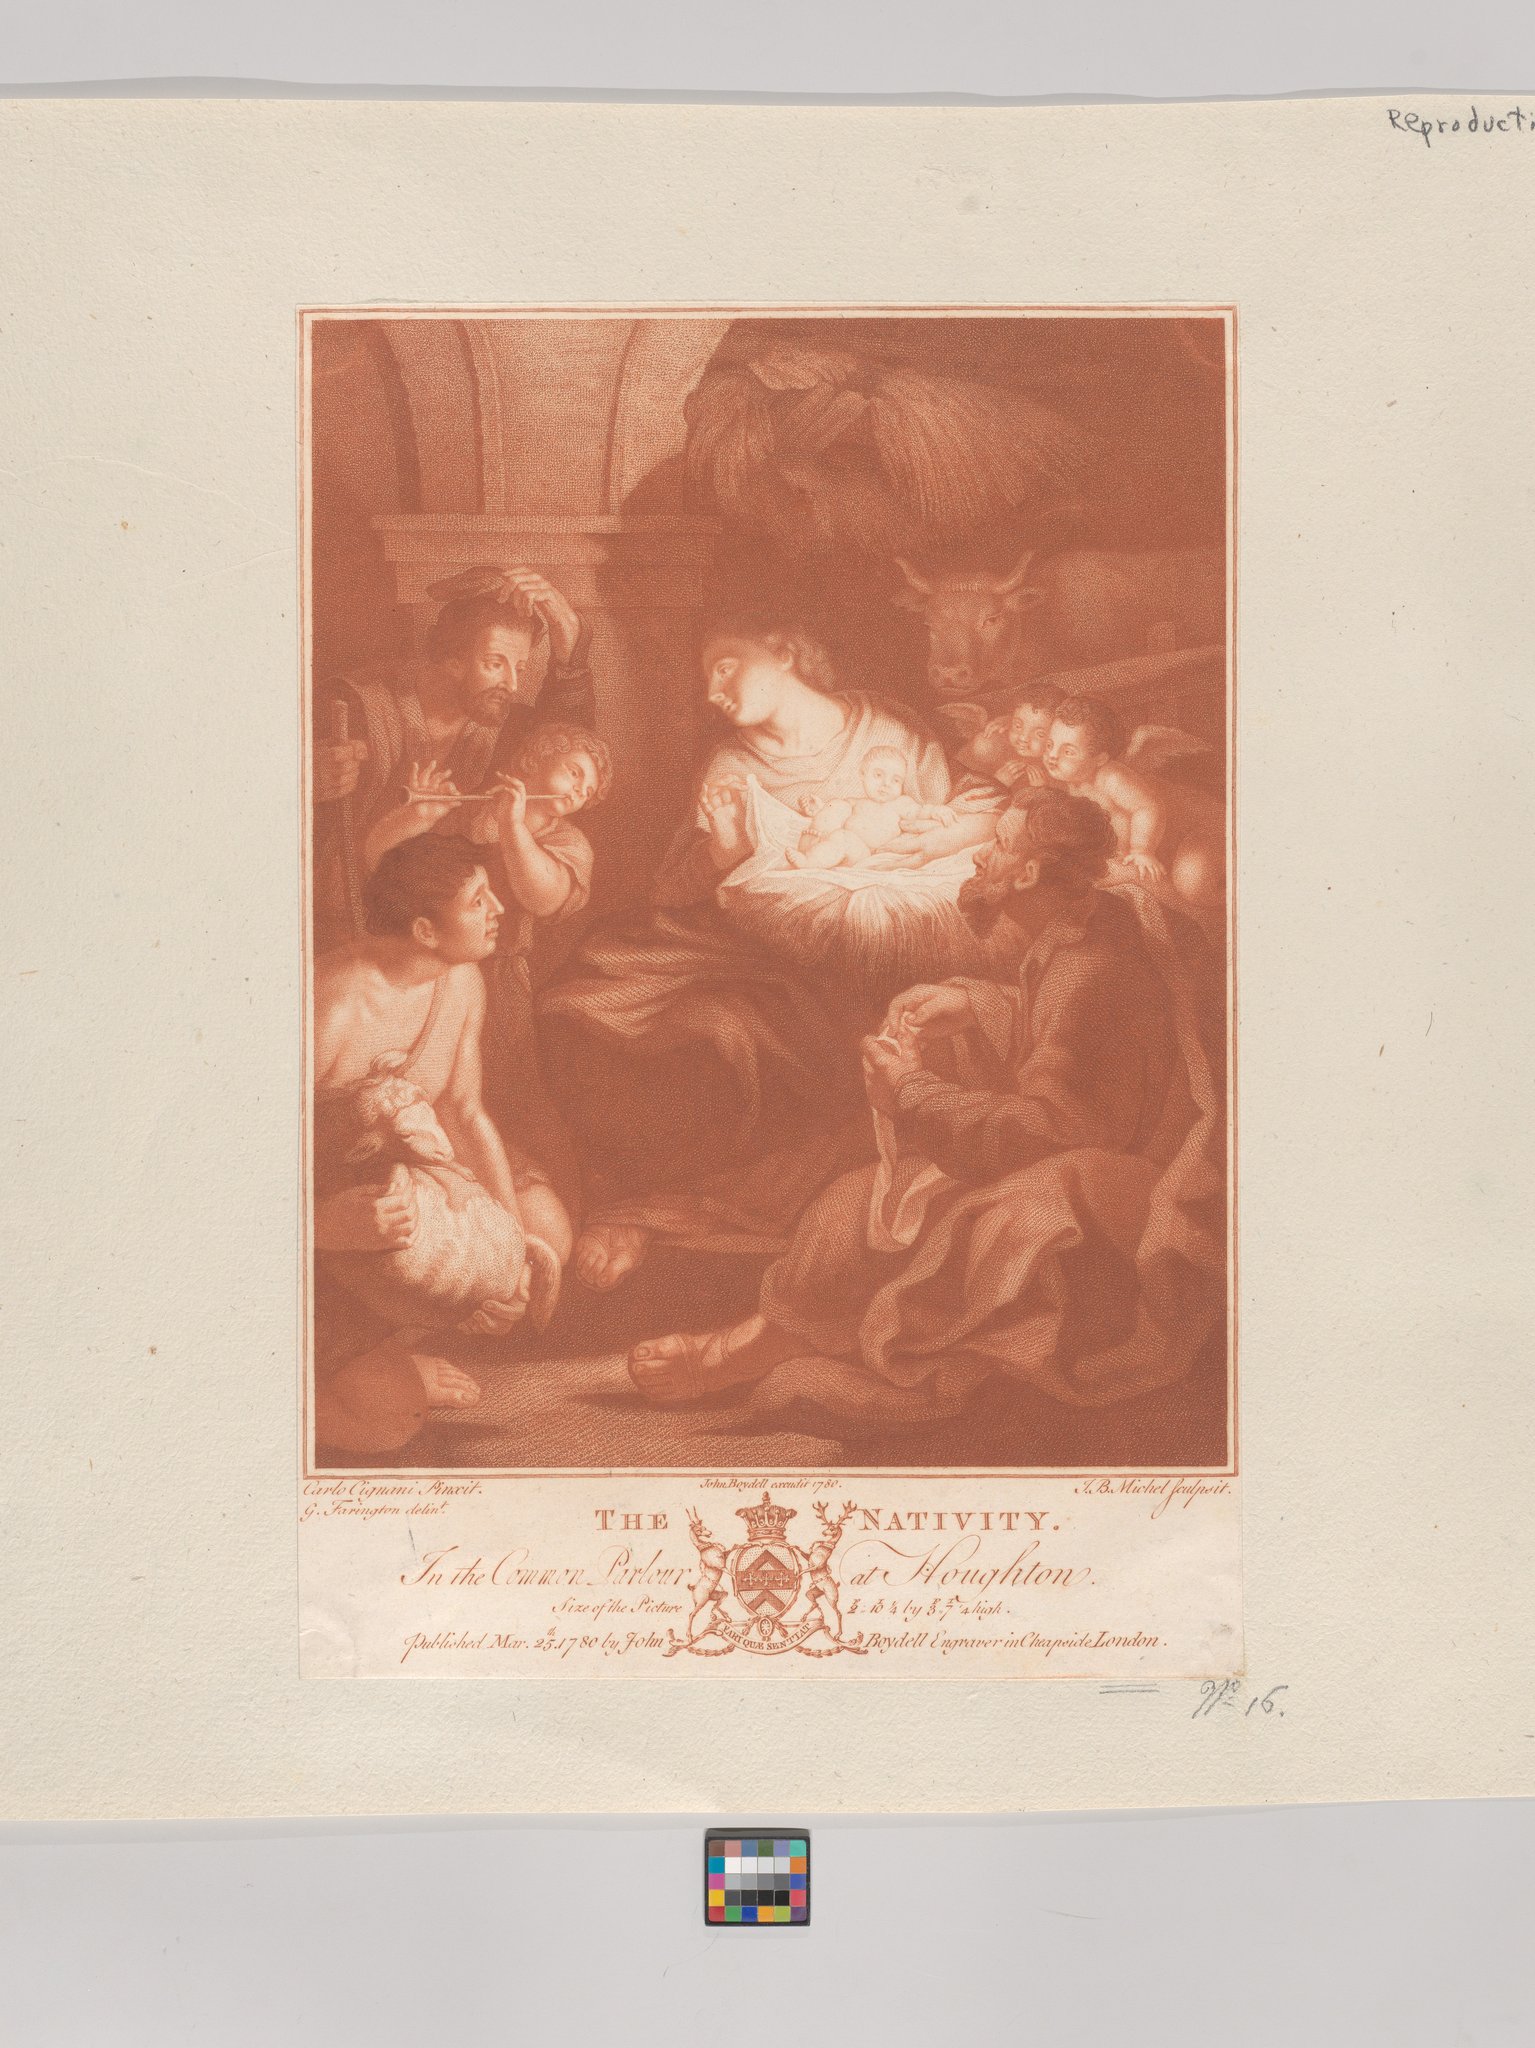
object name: print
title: The Nativity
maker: jean-baptiste michel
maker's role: artist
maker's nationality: french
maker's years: 1748-1804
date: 1780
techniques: printing, engraving